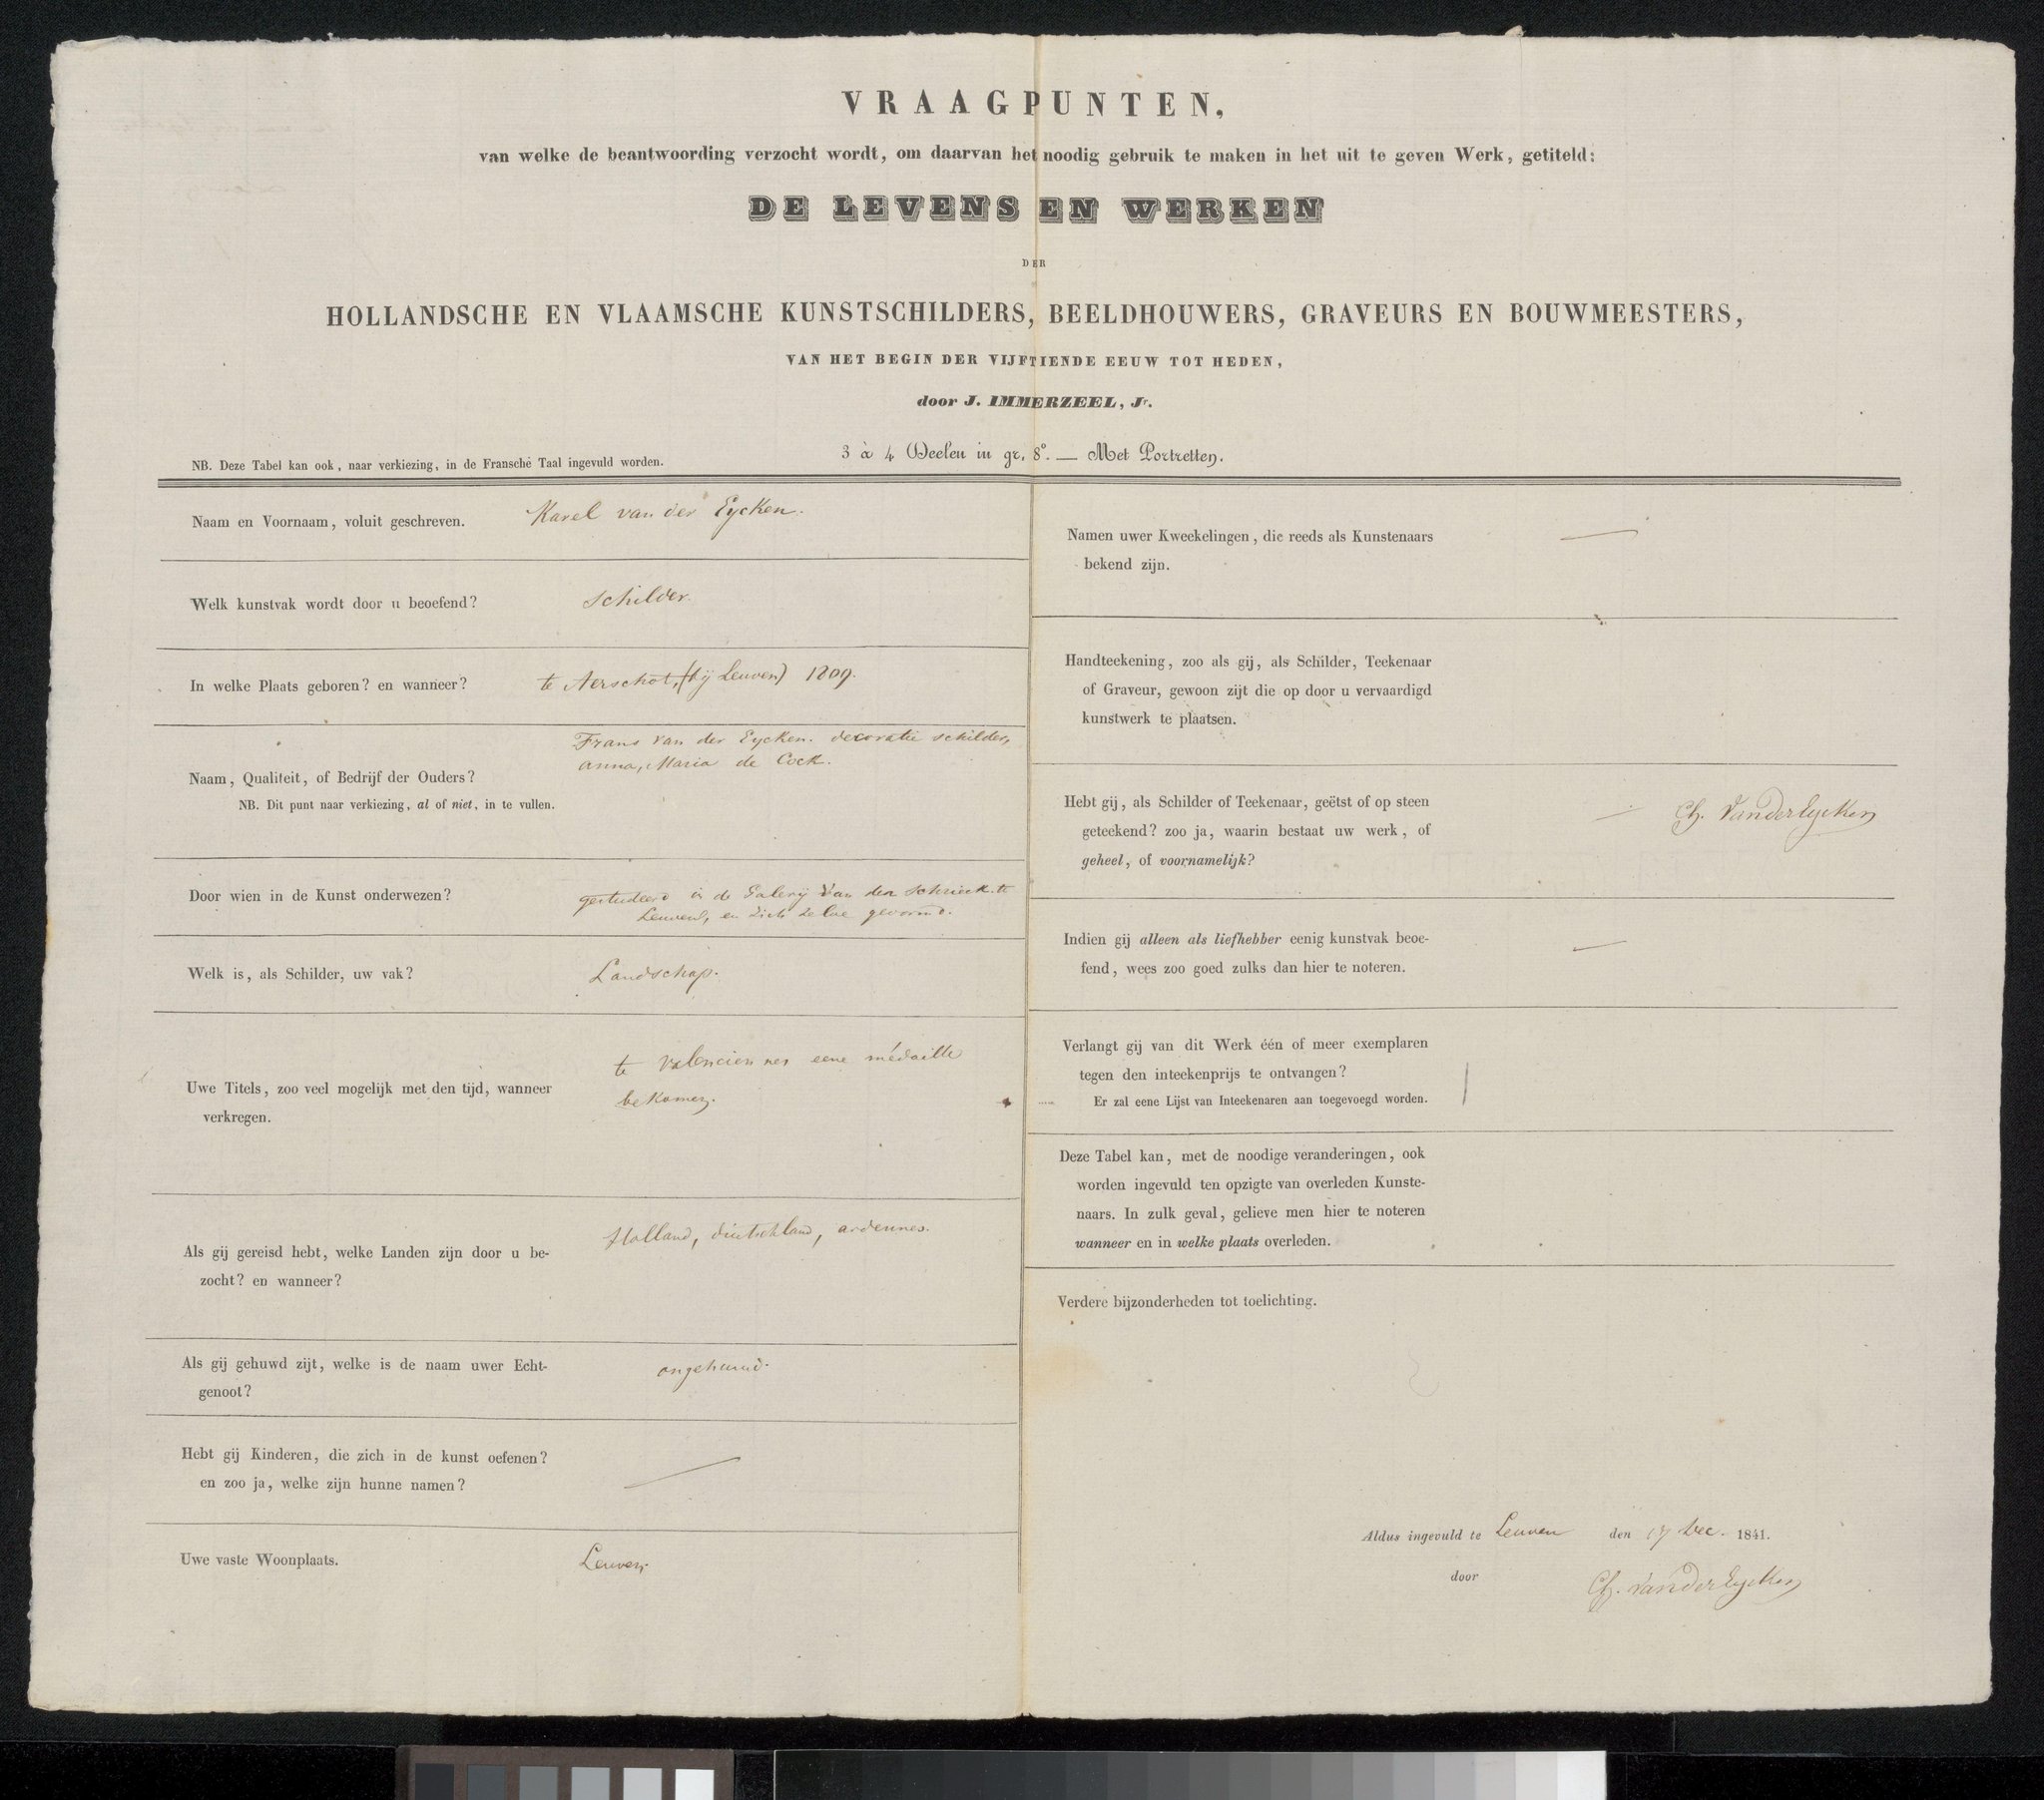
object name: manuscript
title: Enquêteformulier ingevuld door Charles Van den Eycken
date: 1841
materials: ink, paper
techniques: pen, printing, writing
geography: leuven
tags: louvain, charles van den eycken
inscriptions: inscription: ‘Vraagpunten,/ van welke de beantwoording verzocht wordt, om daarvan het noodig gebruik te maken in het uit te geven Werk, getiteld: De levens en werken/ der Hollandsche en Vlaamsche kunstschilders, beeldhouwers,/ graveurs en bouwmeesters, van het begin der vijftiende eeuw tot heden/ door J. Immerzeel, Jr.’, watermark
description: Opgenomen in: Immerzeel, J. Jr., De levens en werken der Hollandsche en Vlaamsche kunstschilders, beeldhouwers, graveurs en bouwmeesters, van het begin der vijftiende eeuw tot heden, Amsterdam: J.C. van Kesteren, 1842-1843.